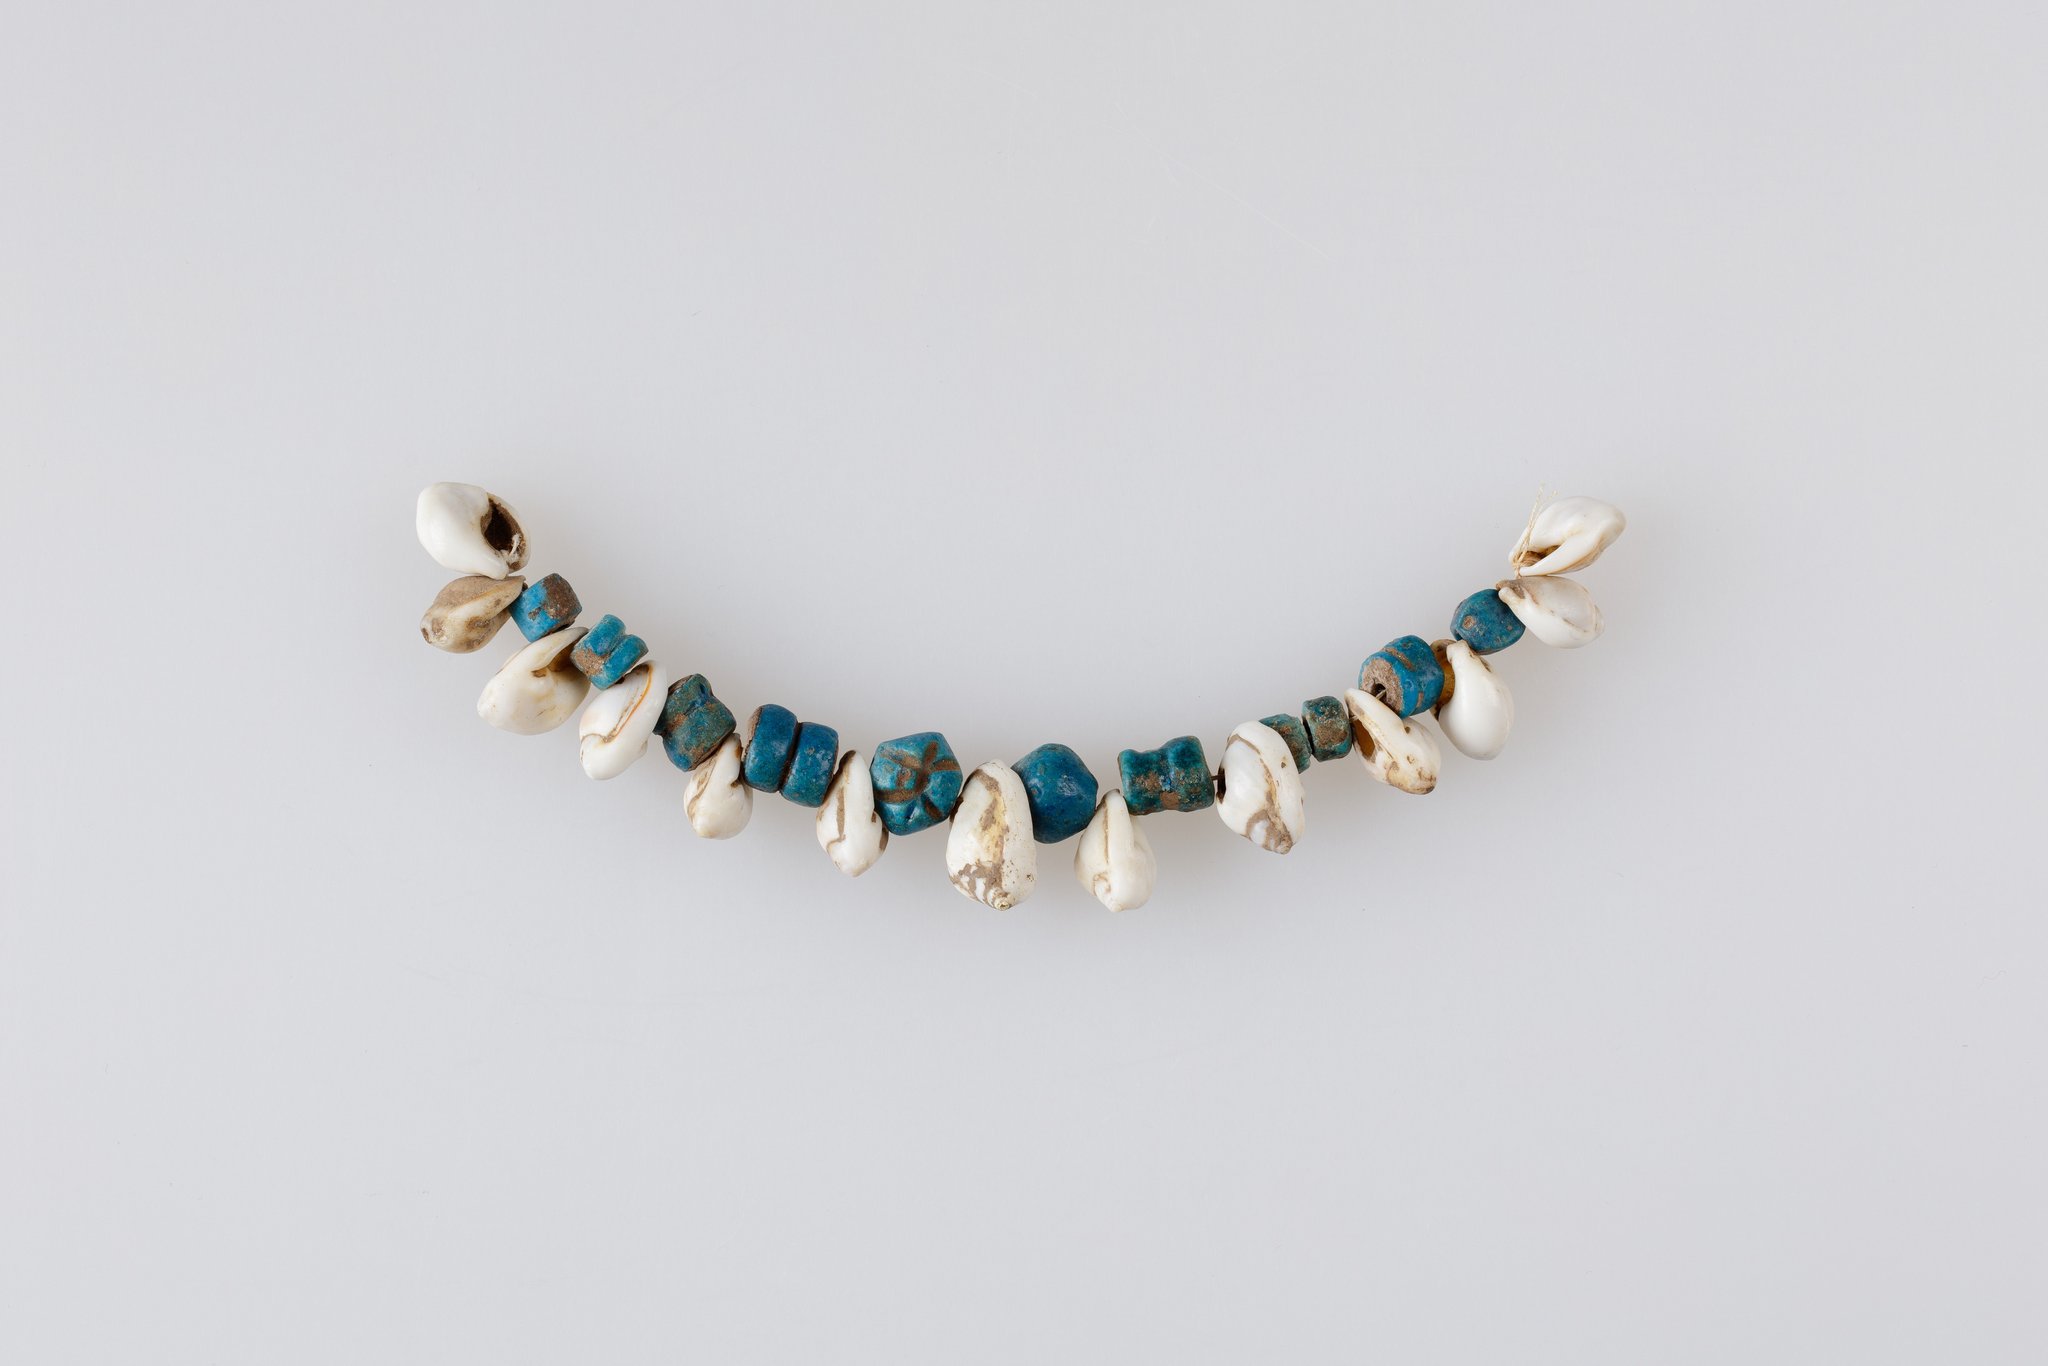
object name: bead, string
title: String of beads and shells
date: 1070-343 BCE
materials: faience, shell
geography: egypt